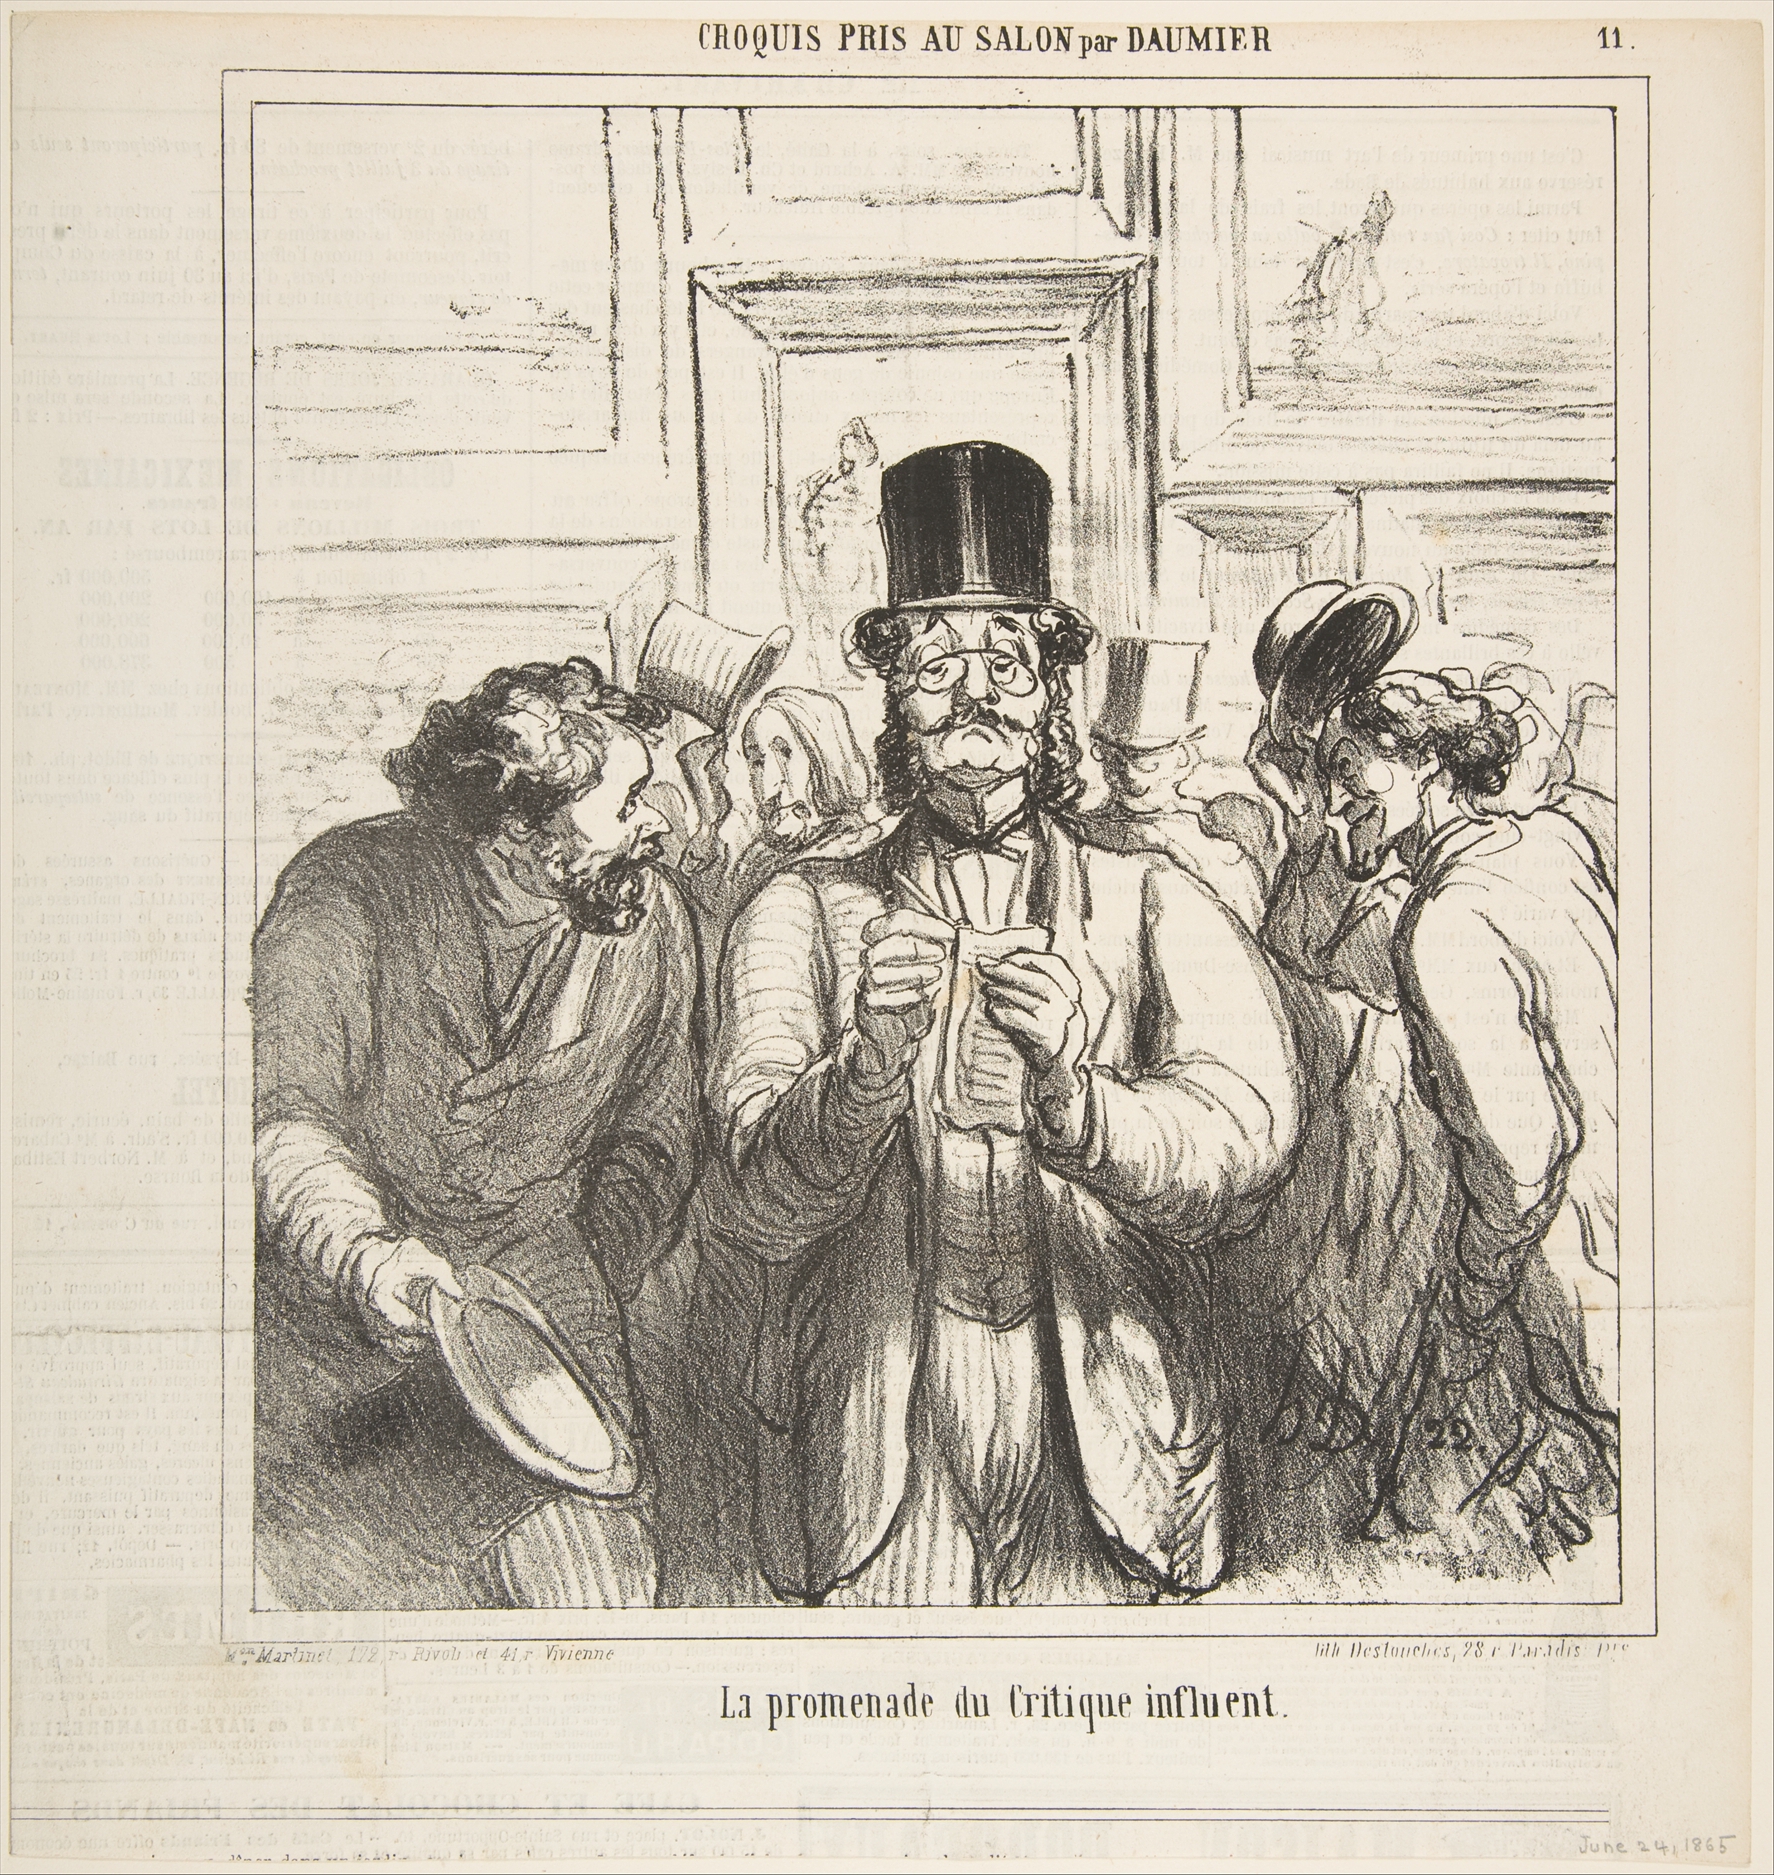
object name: print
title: Walk-through of an influential critic, from 'Sketches from the Salon,' published in 'Le Charivari,' June 24, 1865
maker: honoré daumier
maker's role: artist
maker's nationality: french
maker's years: 1808-1879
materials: paper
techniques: lithograph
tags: hats,men